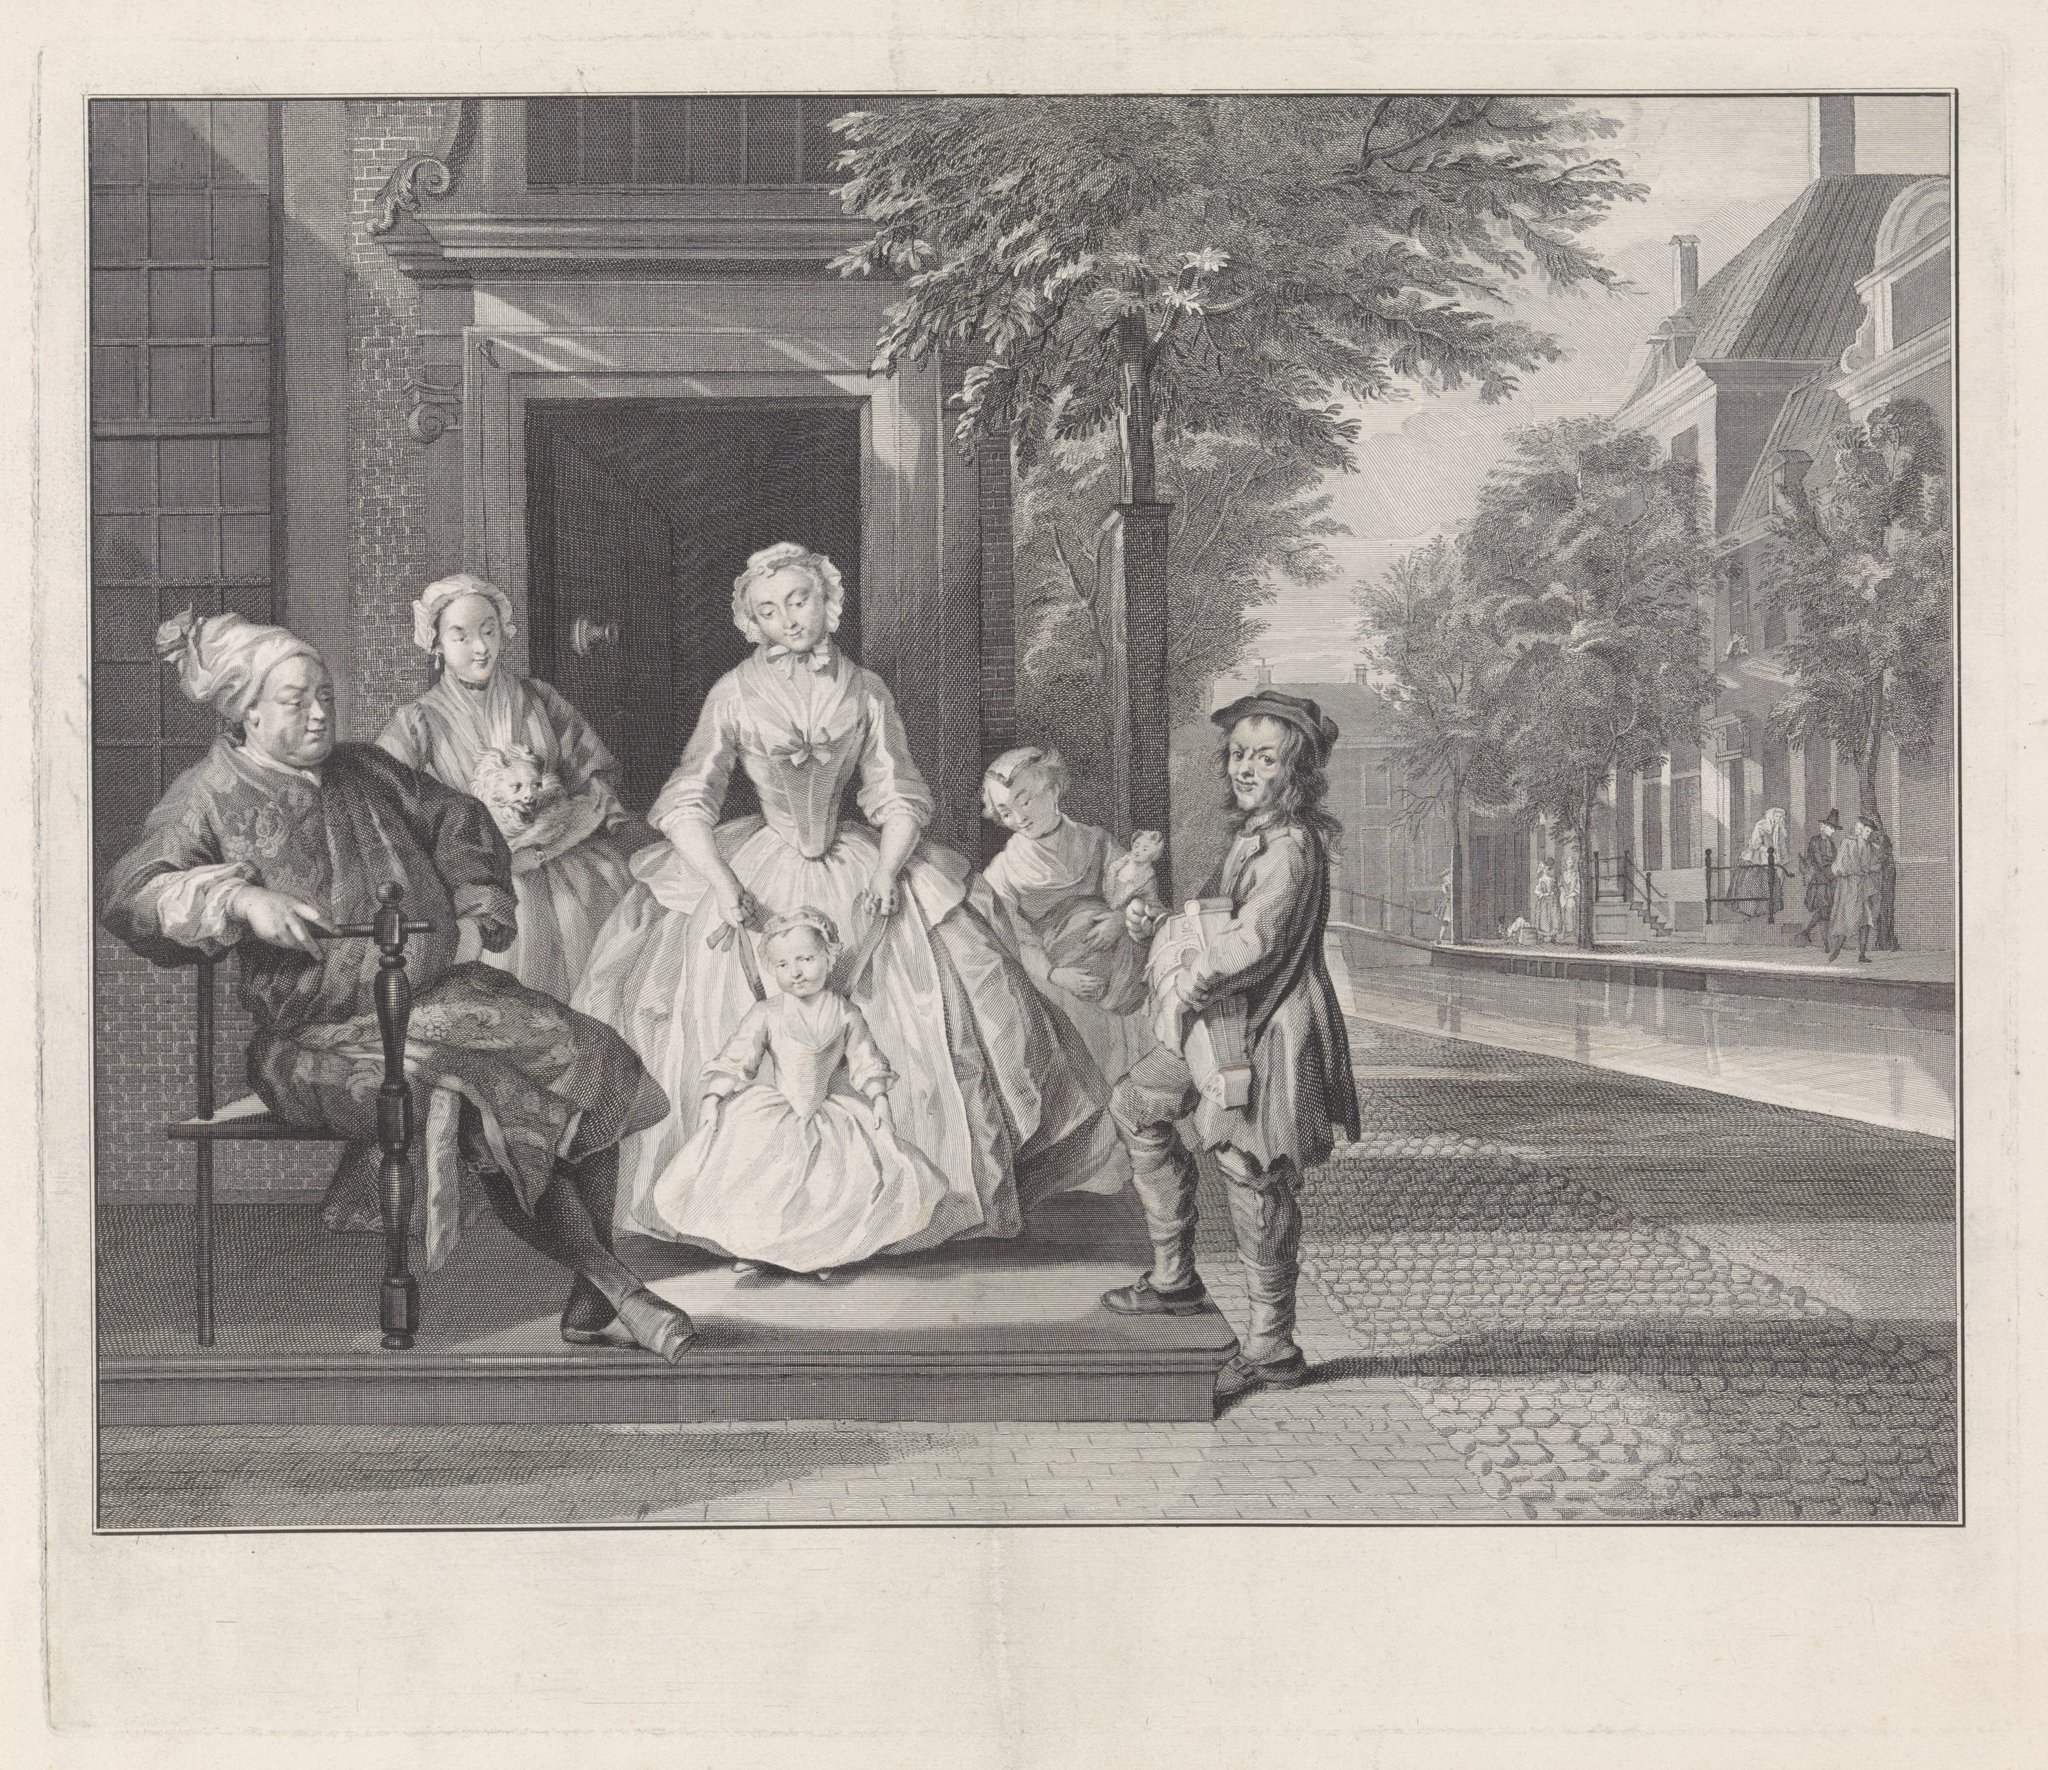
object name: print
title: De liereman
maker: jacob houbraken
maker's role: draughtsman, print maker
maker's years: 1698-1780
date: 1762-1764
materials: paper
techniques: engraving, etching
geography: amsterdam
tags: parents with their children, hurdy-gurdy player - cc - out of doors, canals, waters (in city) (+ city(-scape) with figures, staffage)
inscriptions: collector's mark: Lugt 240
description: Op een stoep voor een deuropening in een stad zit een gezin waaronder twee jonge kinderen. Naast hen staat een straatmuzikant met een draailier. Rechts een gracht.